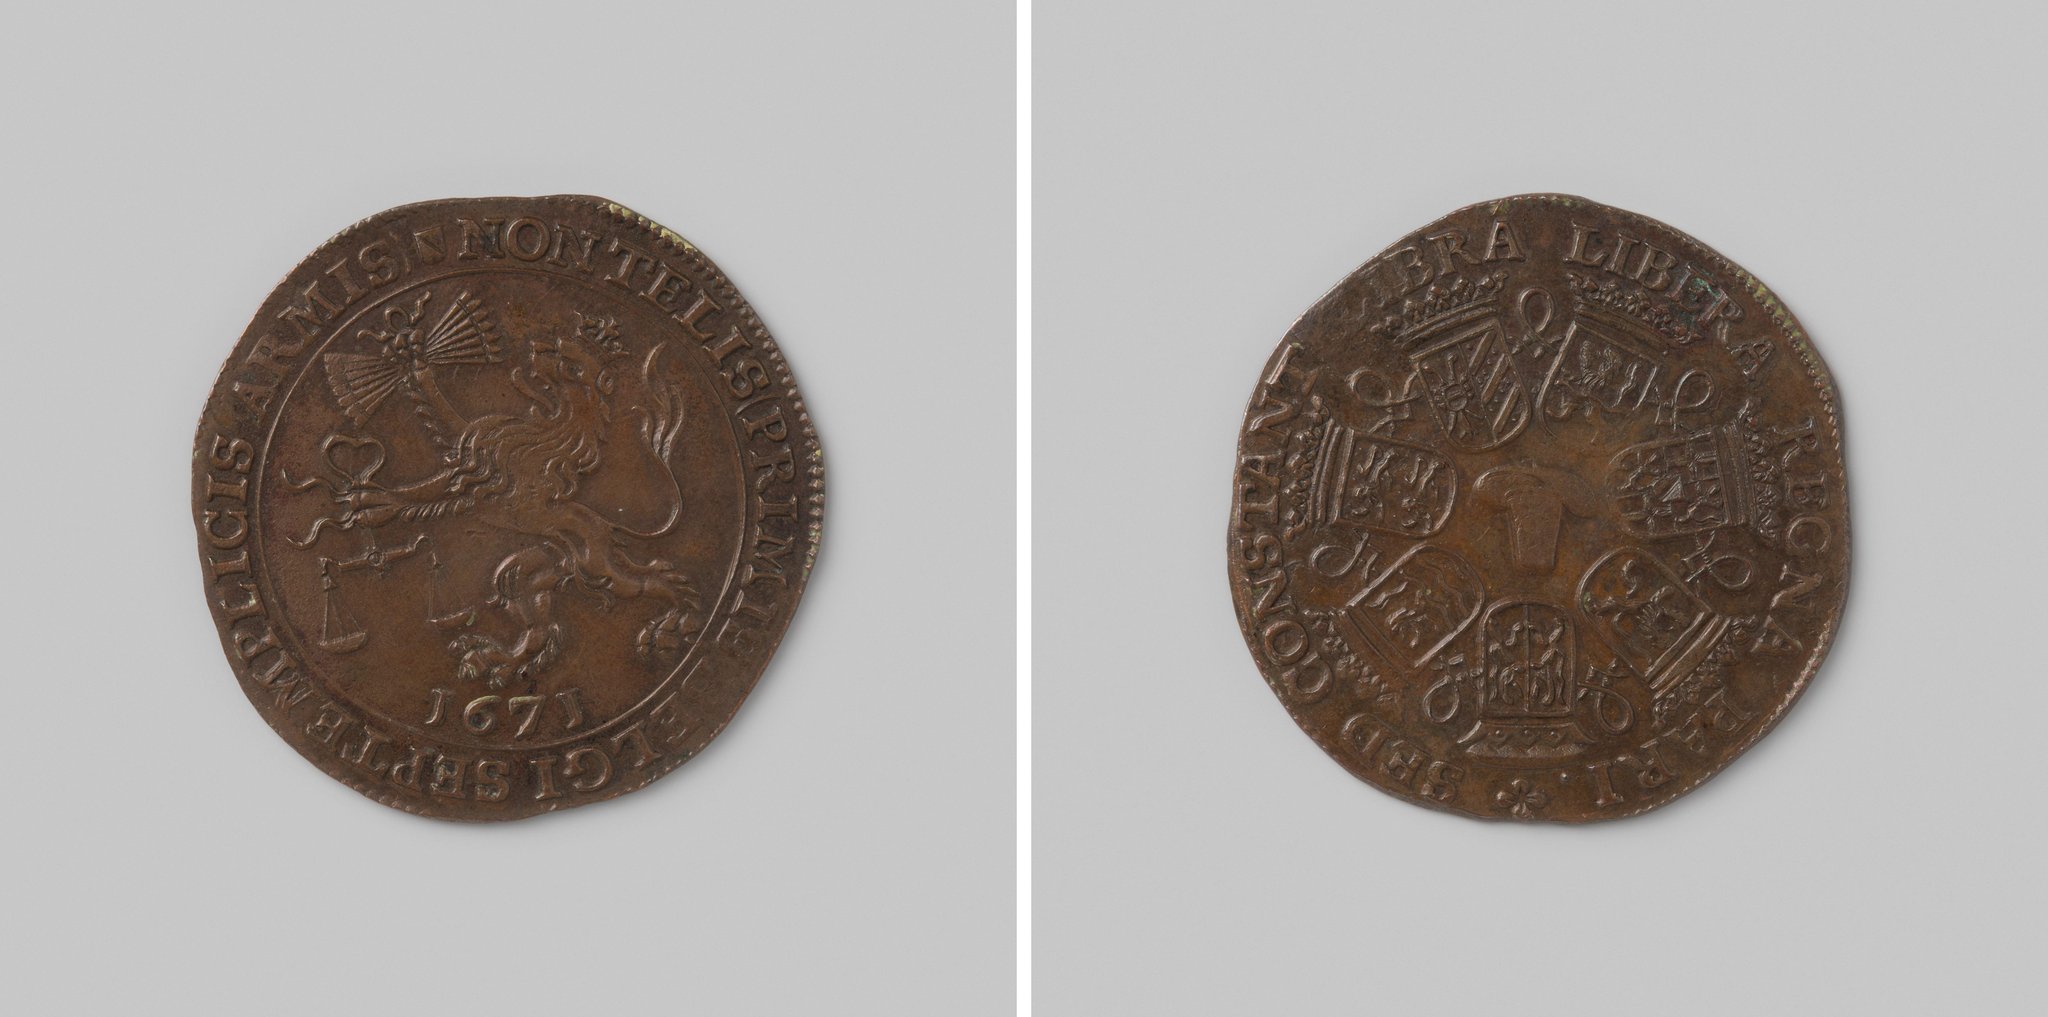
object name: history medal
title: Verlangen naar Vrede door de Nederlanden, 1671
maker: Anonymous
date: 1671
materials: bronze, ivory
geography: utrecht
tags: netherlands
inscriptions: circumscription: ‘SED CONSTANT LIBRA REGNA PARI’, circumscription: ‘NONTELIS PRIMIS BELGI SEPTEMPLICIS ARMIS’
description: Koperen munt op deksel van rond (walvis)ivoren doosje. Voorzijde: gekroonde leeuw met bundel van zeven pijlen in rechter- en weegschaal in linkerklauw boven jaartal binnen omschrift. Keerzijde: vrijheidshoed, omgeven door rand van zeven met lint samengebonden gekroonde wapenschilden van de zeven provinciën binnen omschrift.